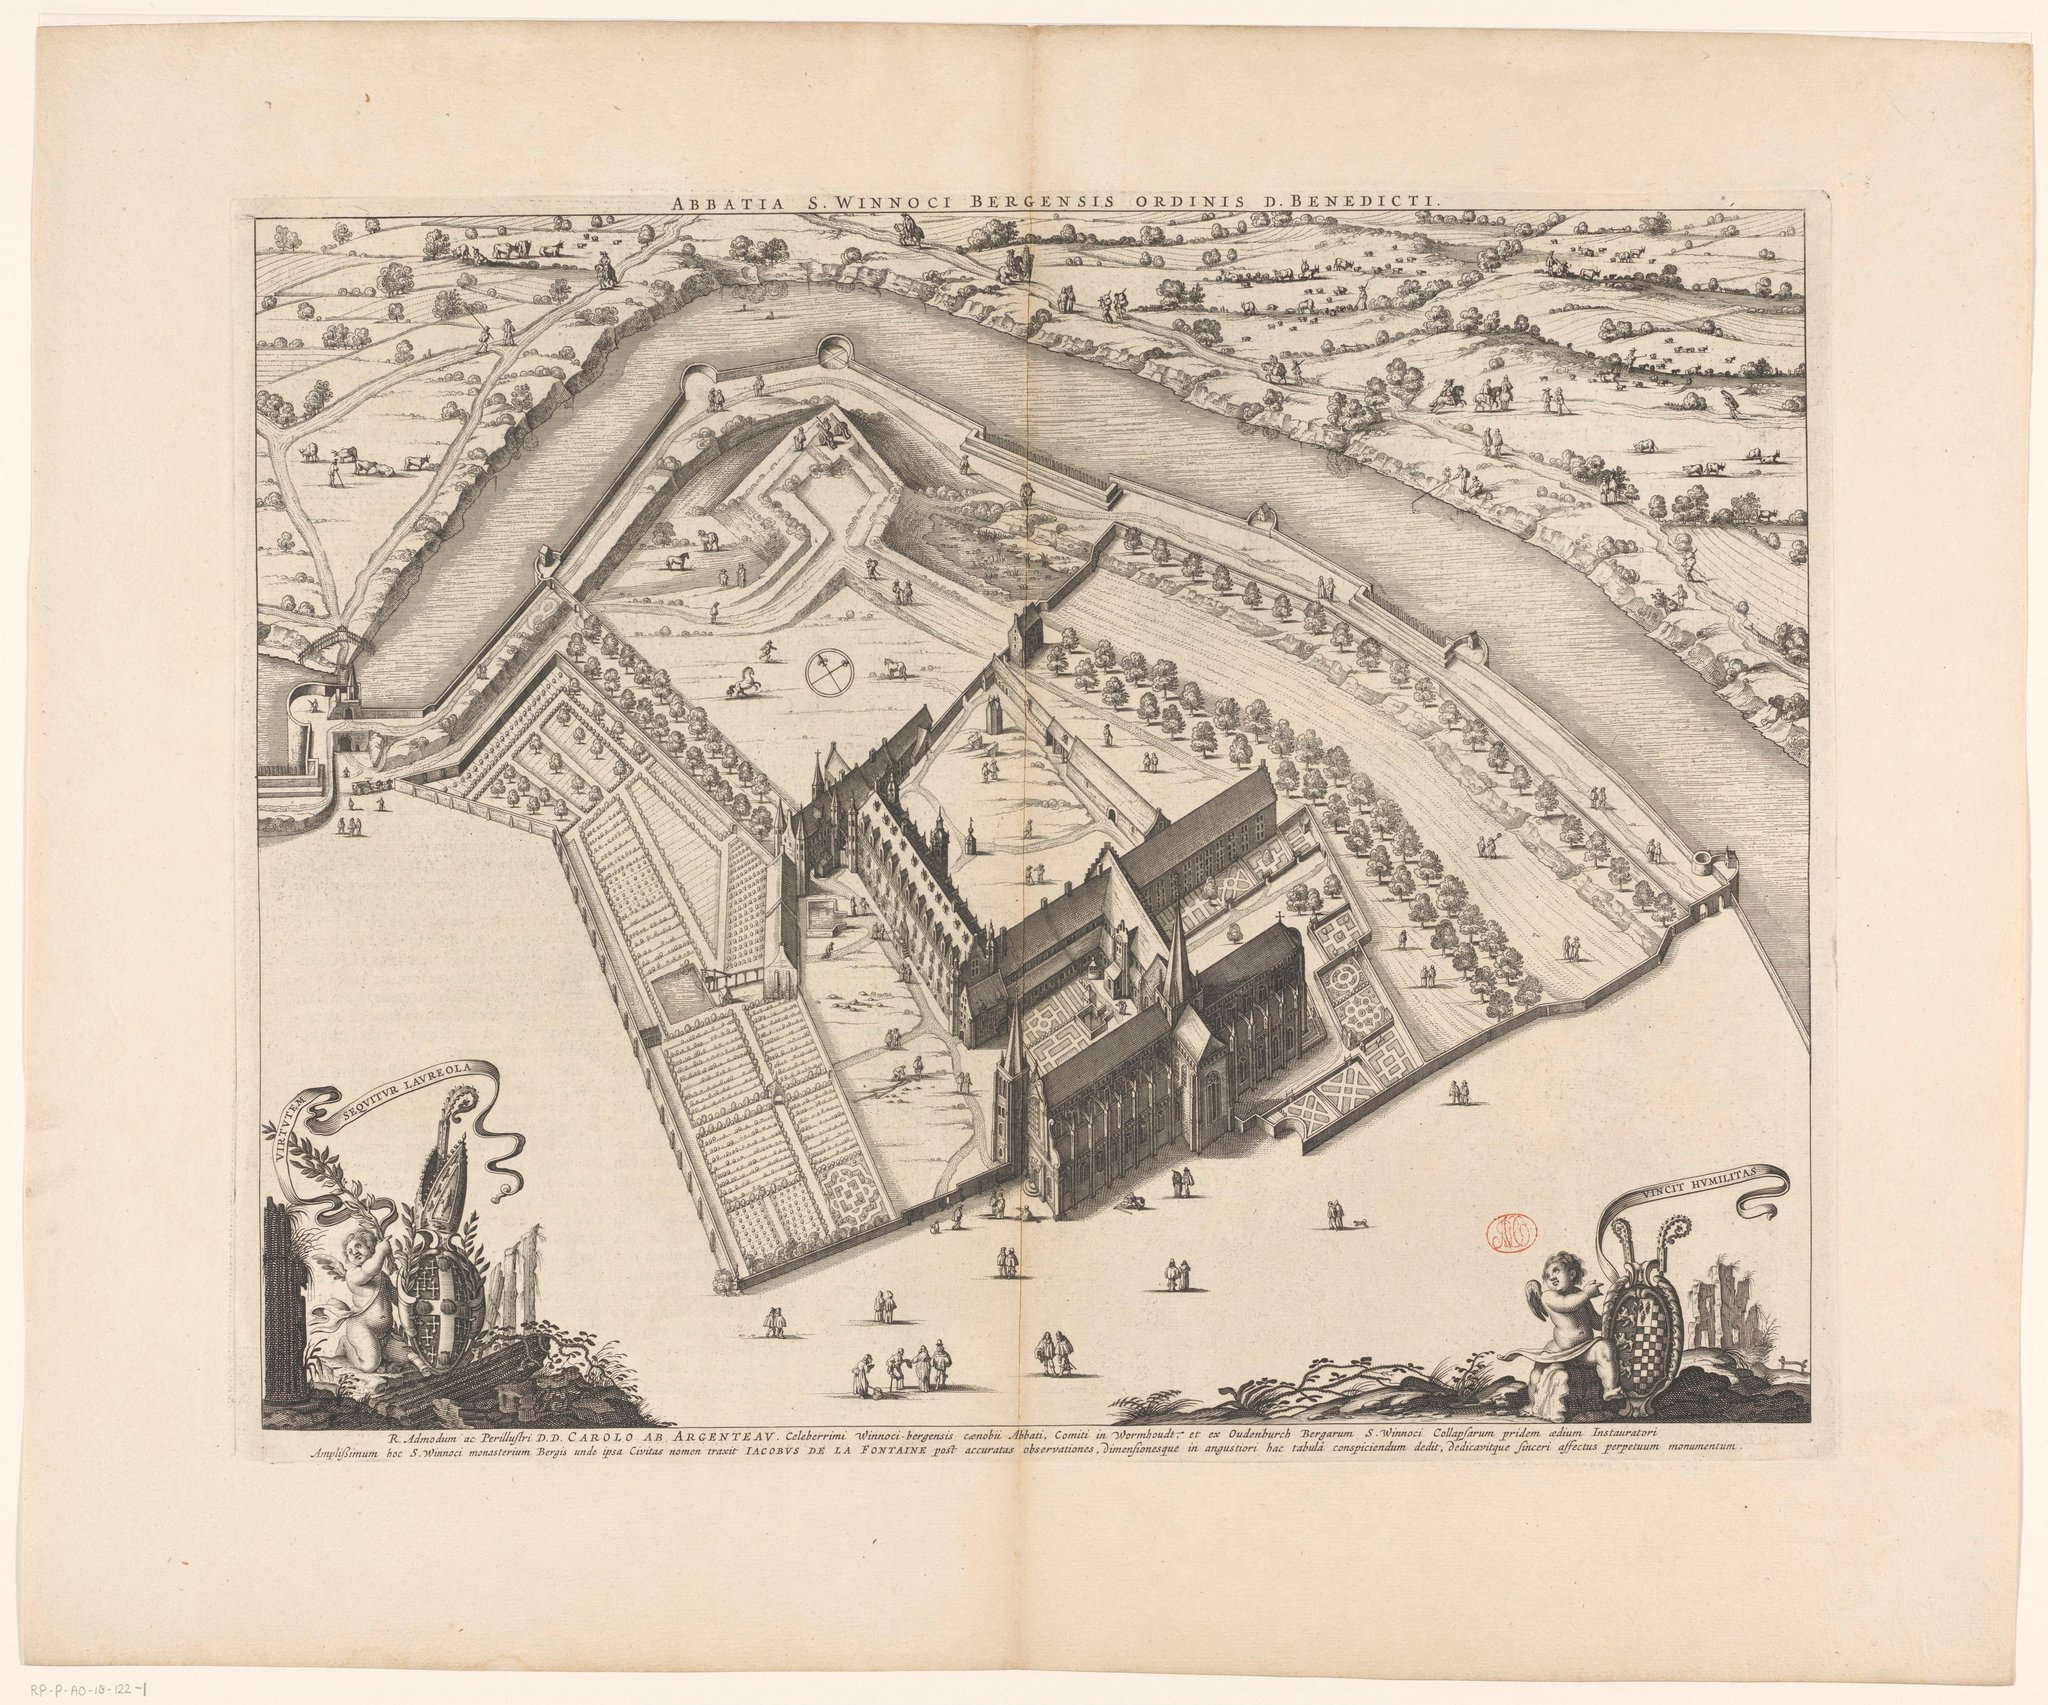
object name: print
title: Gezicht op de abdij van Sint-Winoksbergen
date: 1652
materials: paper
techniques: engraving, etching, letterpress printing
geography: sint-winoksbergen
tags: maps of separate countries or regions, abbey, monastery, convent ~ roman catholic church, armorial bearing, heraldry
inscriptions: collector's mark: Lugt 195, collector's mark: Lugt 2228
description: Gezicht op de abdij van Winoksbergen in vogelvluchtperspectief. De titel in een balk boven de prent. Linksonder een voorstelling met een putto en het wapenschild van abt Charles d'Argenteau. Rechtsonder een andere putto met wapenschild. Met Nederlandse tekst op verso.